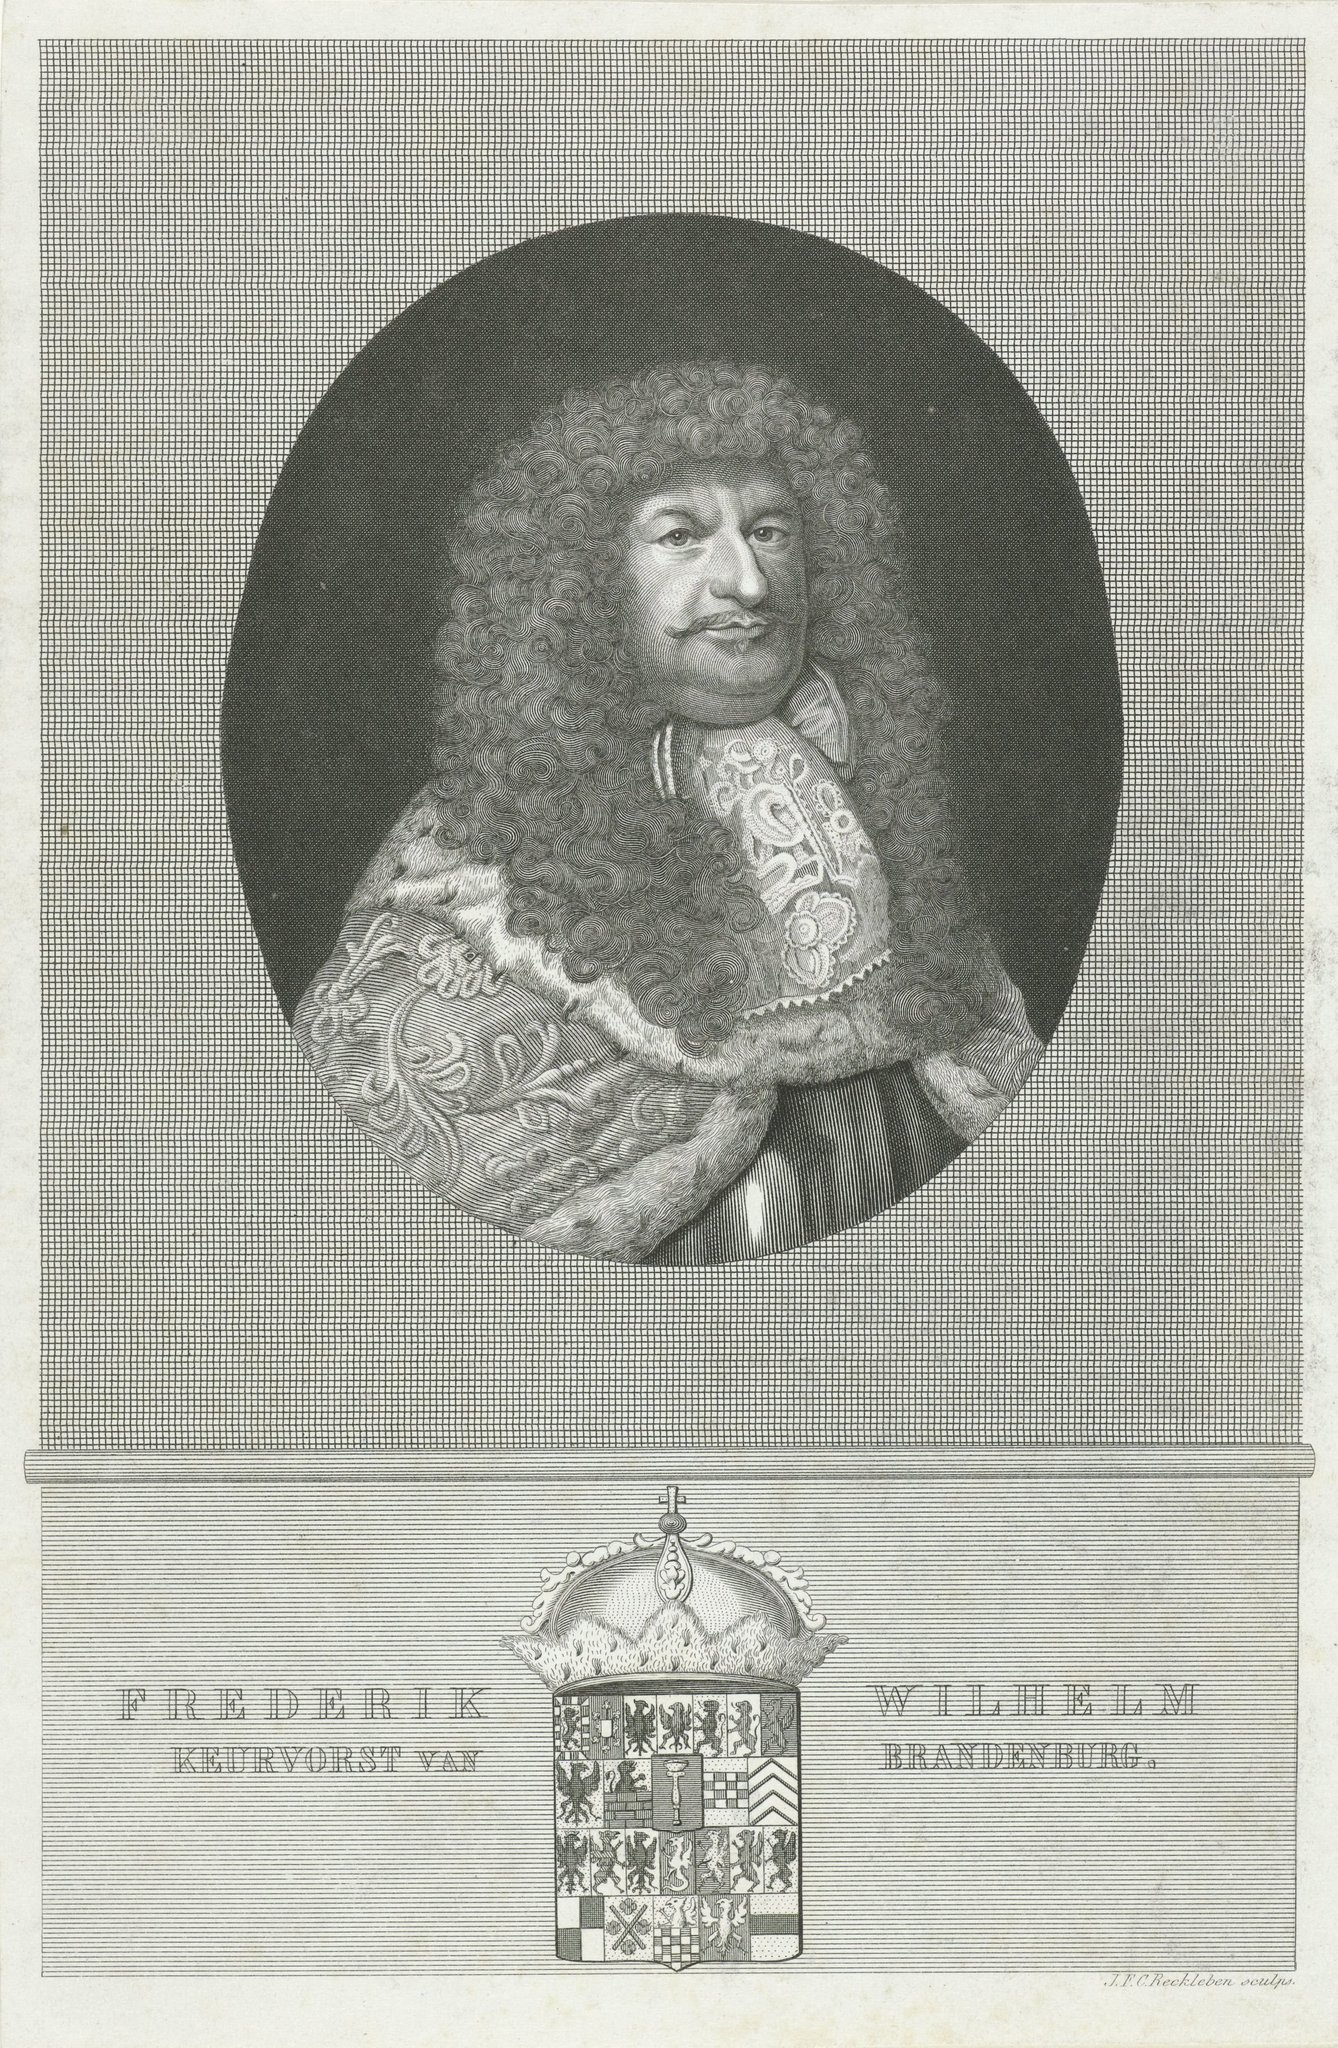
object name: print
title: Portret van Frederik Willem, keurvorst van Brandenburg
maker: jan frederik christiaan reckleben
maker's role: print maker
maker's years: 1819-1879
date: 1866-1868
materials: paper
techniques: engraving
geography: amsterdam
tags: berlin, frederik willem van brandenburg (i)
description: Illustratie in: Arend, Johannes Pieter. Algemeene geschiedenis des vaderlands van de vroegste tijden tot op heden. 5 delen, Amsterdam: Schleijer, J.F. 1840-1884, dl. 3.5, p. 644.